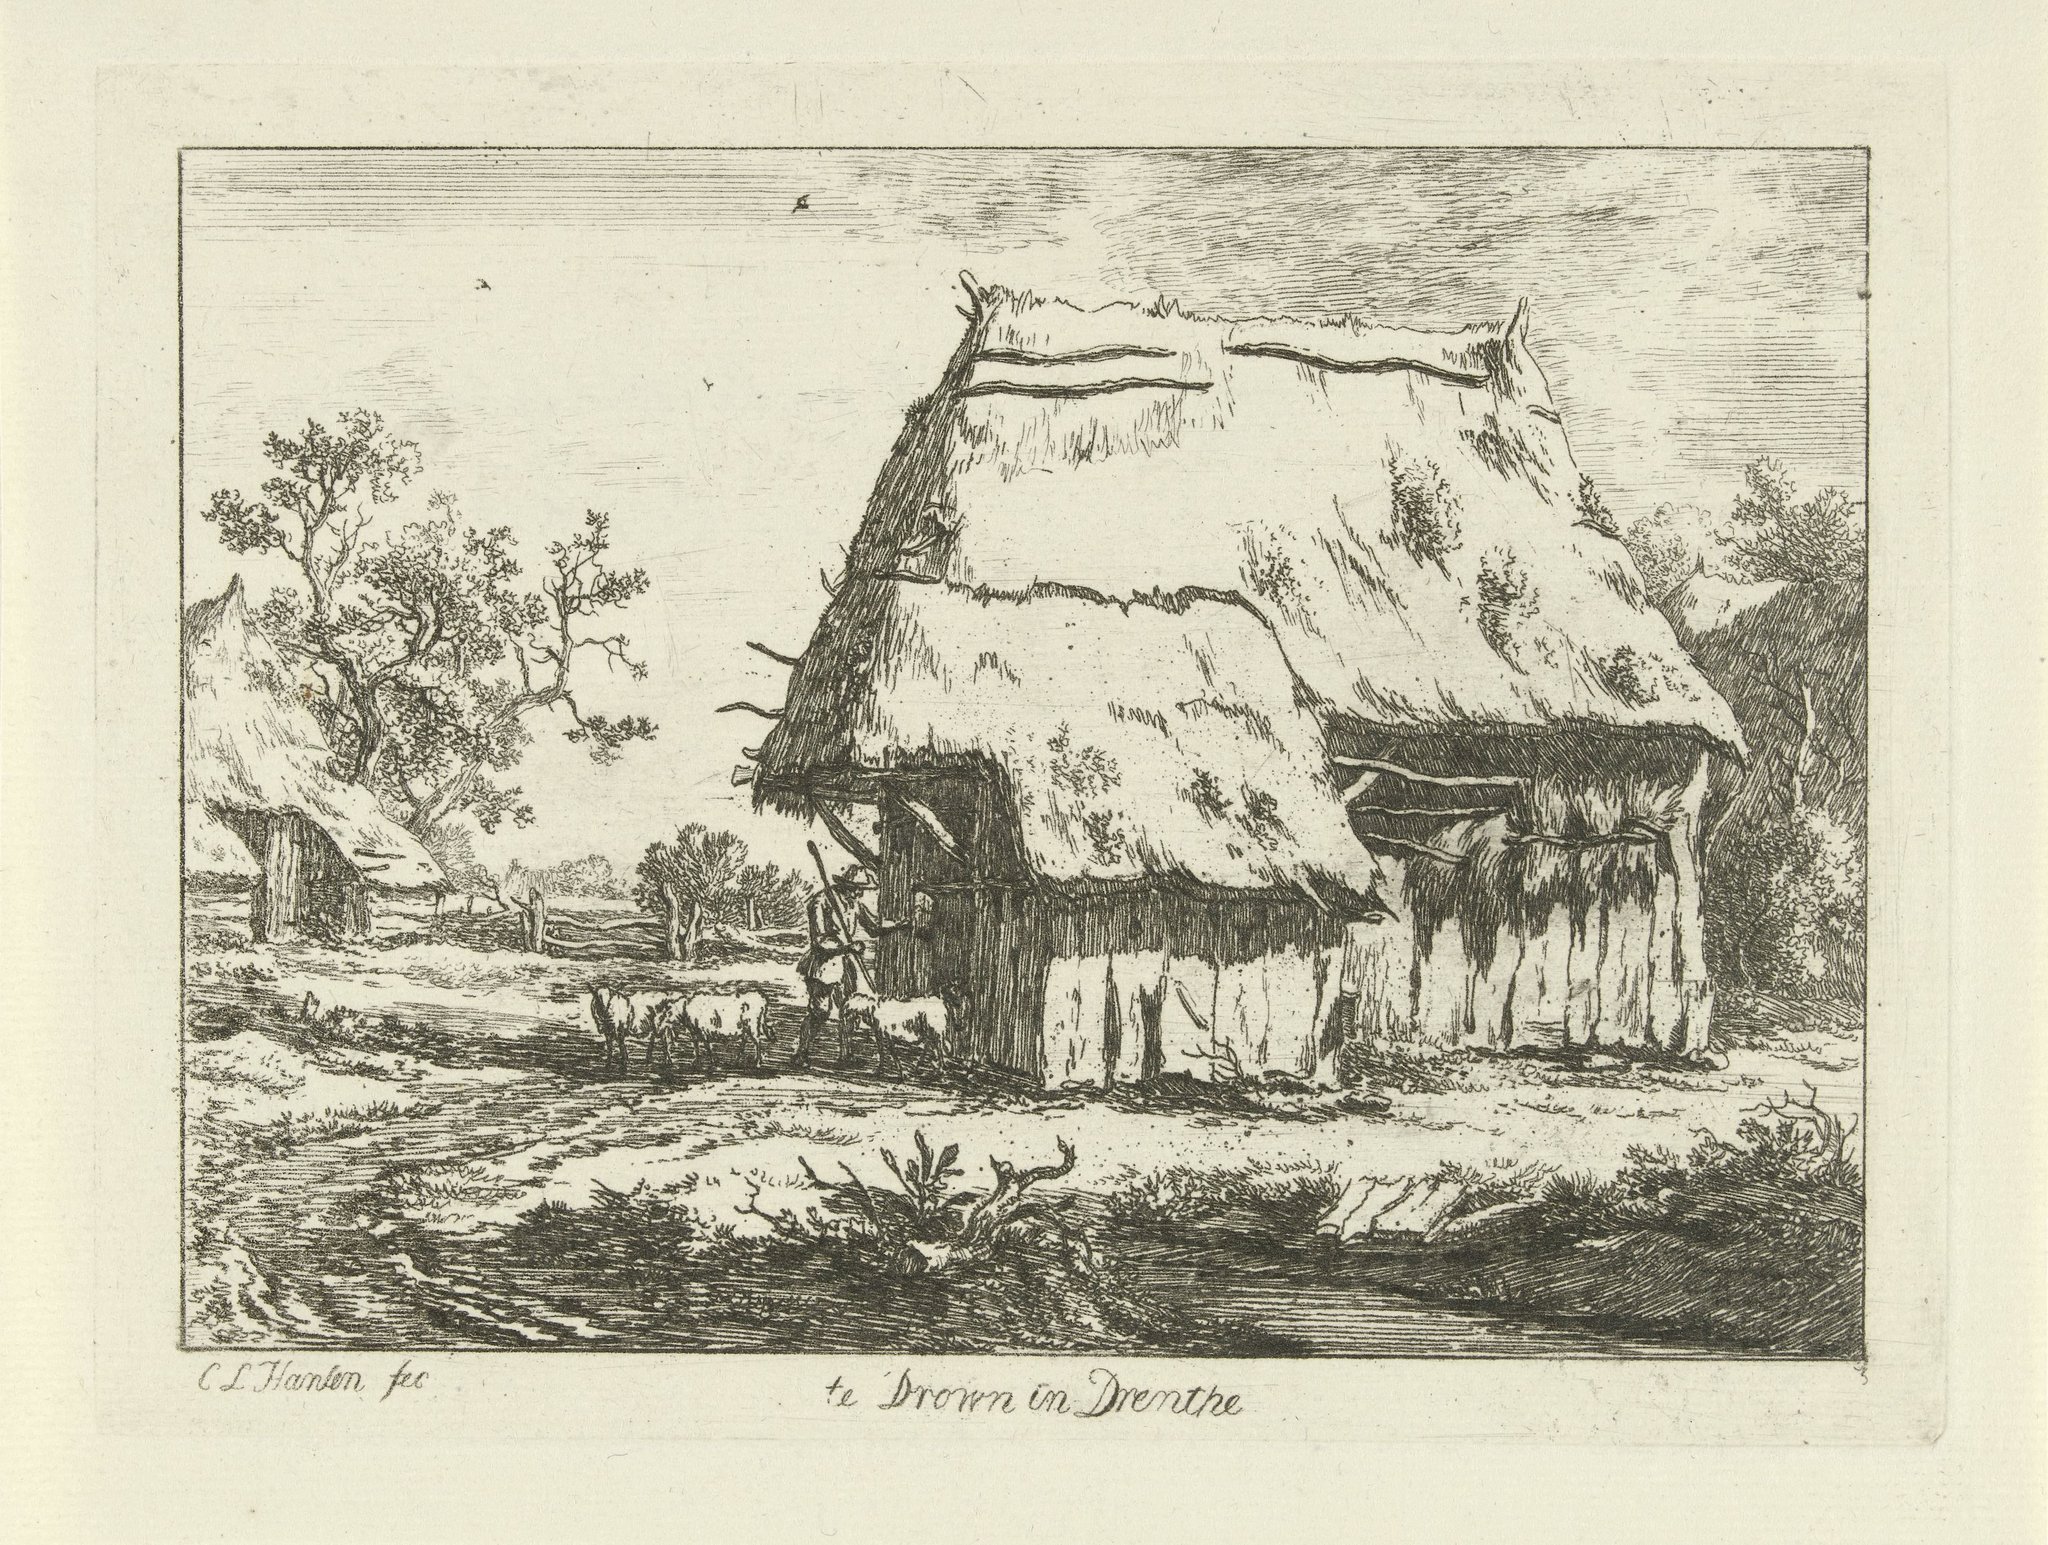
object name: print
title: Herder bij een schaapskooi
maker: carel lodewijk hansen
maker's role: draughtsman, painter, print maker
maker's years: 1765-1840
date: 1780-1840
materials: paper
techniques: etching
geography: netherlands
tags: herding, herdsman, herdswoman, shepherd, shepherdess, cowherd, etc., sheep, stall, stable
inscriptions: collector's mark: Lugt 2228